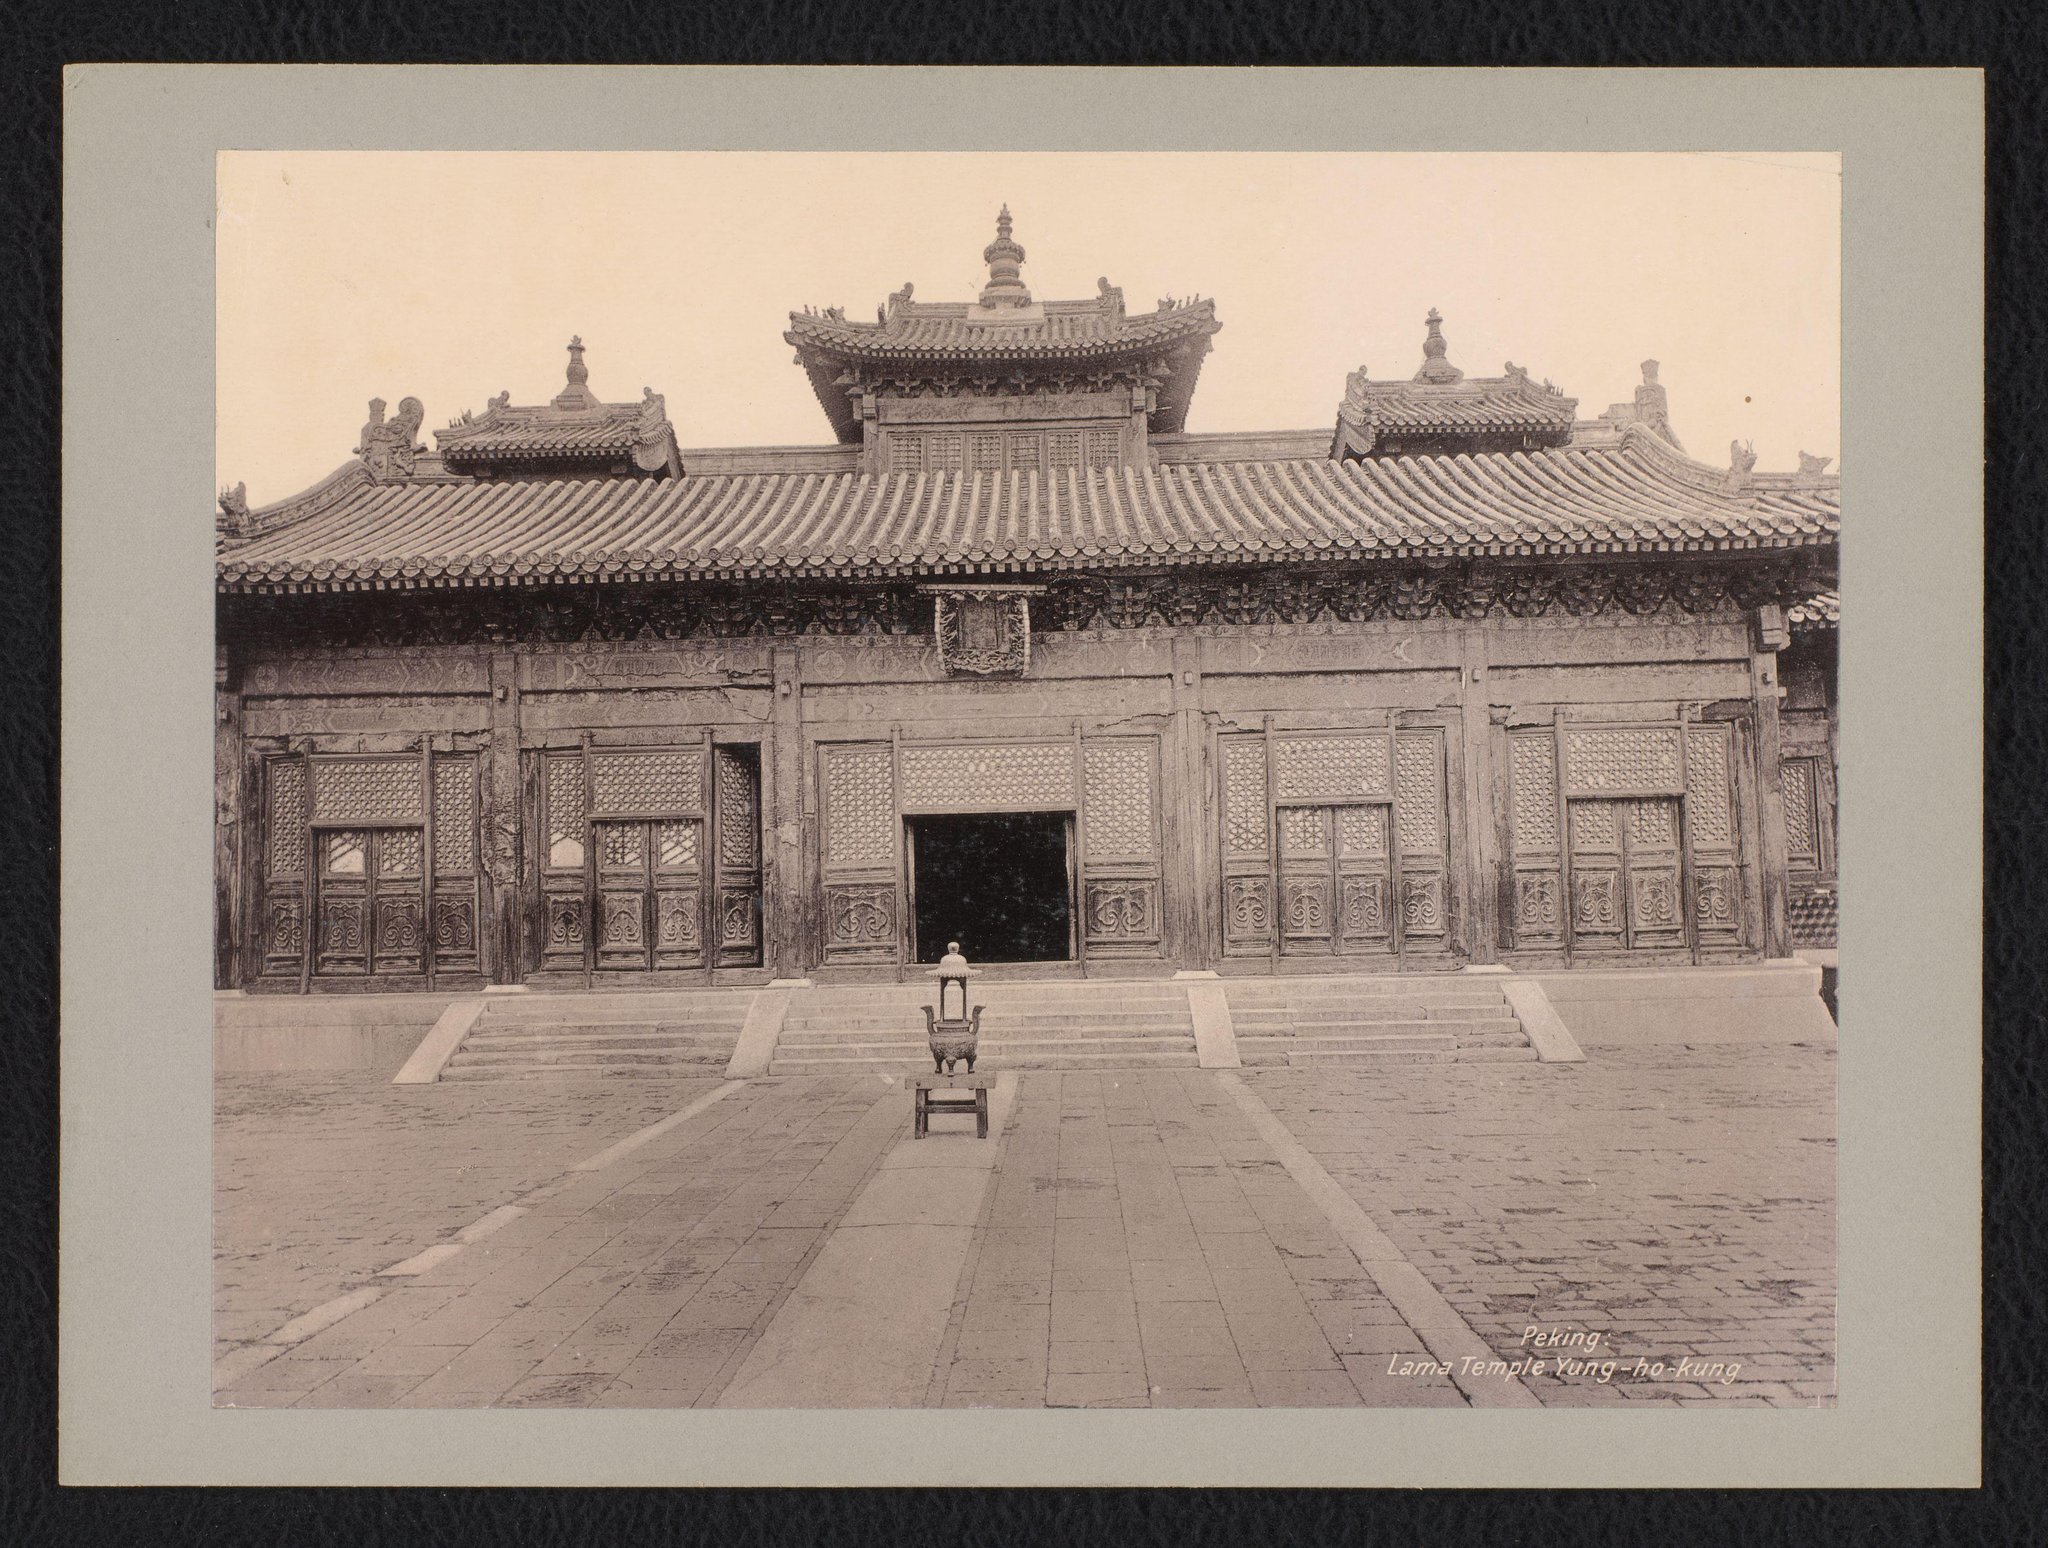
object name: photograph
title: Peking: Lama Temple Yung-ho-kung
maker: Anonymous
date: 1895-1915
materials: cardboard, photographic support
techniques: photograph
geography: beijing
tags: peking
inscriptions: number: ‘7.’